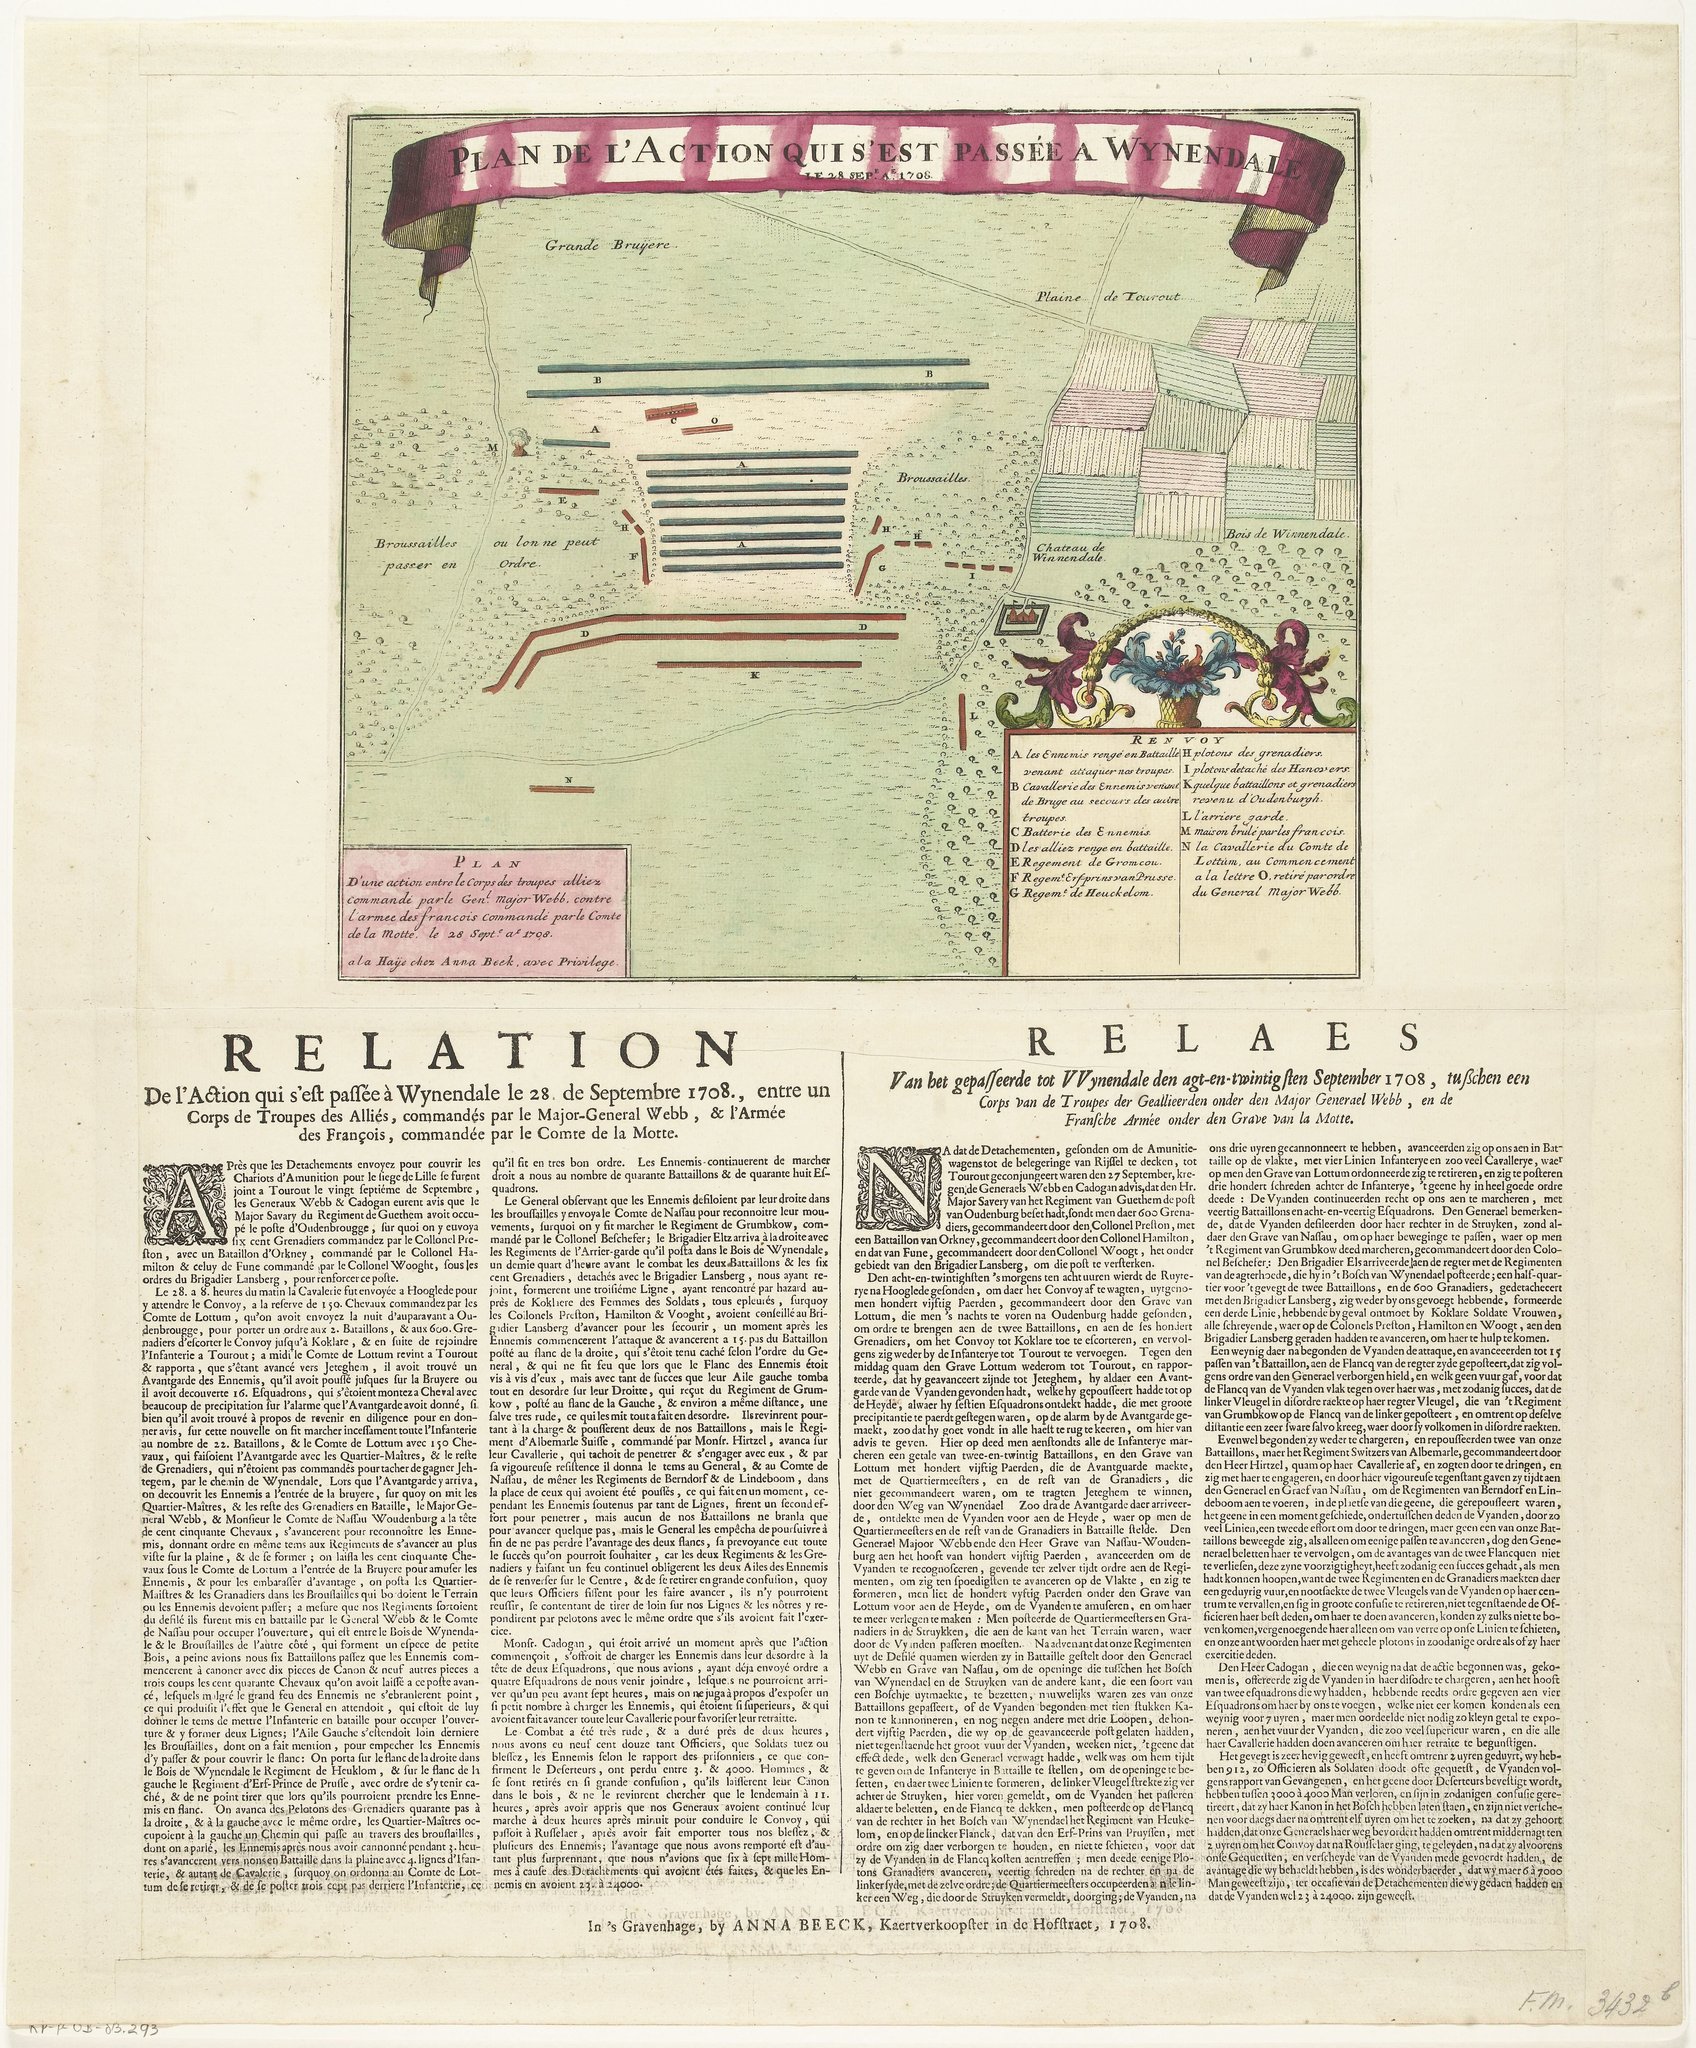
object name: map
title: Plan van de slag bij Wijnendale, 1708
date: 1708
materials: paper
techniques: etching, hand coloring, letterpress printing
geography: the hague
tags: maps of separate countries or regions, battle (+ land forces)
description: Plattegrond van de slag op 28 september 1708 bij Wijnendale in West-Vlaanderen tussen de geallieerde troepen onder generaal-majoor Webb die een konvooi begeleidden en Franse troepen onder Graaf de la Mott. Vastgeplakt onder de plaat een blad met een relaas van het gevecht in 2 kolommen in het Frans en 2 kolommen in het Nederlands.